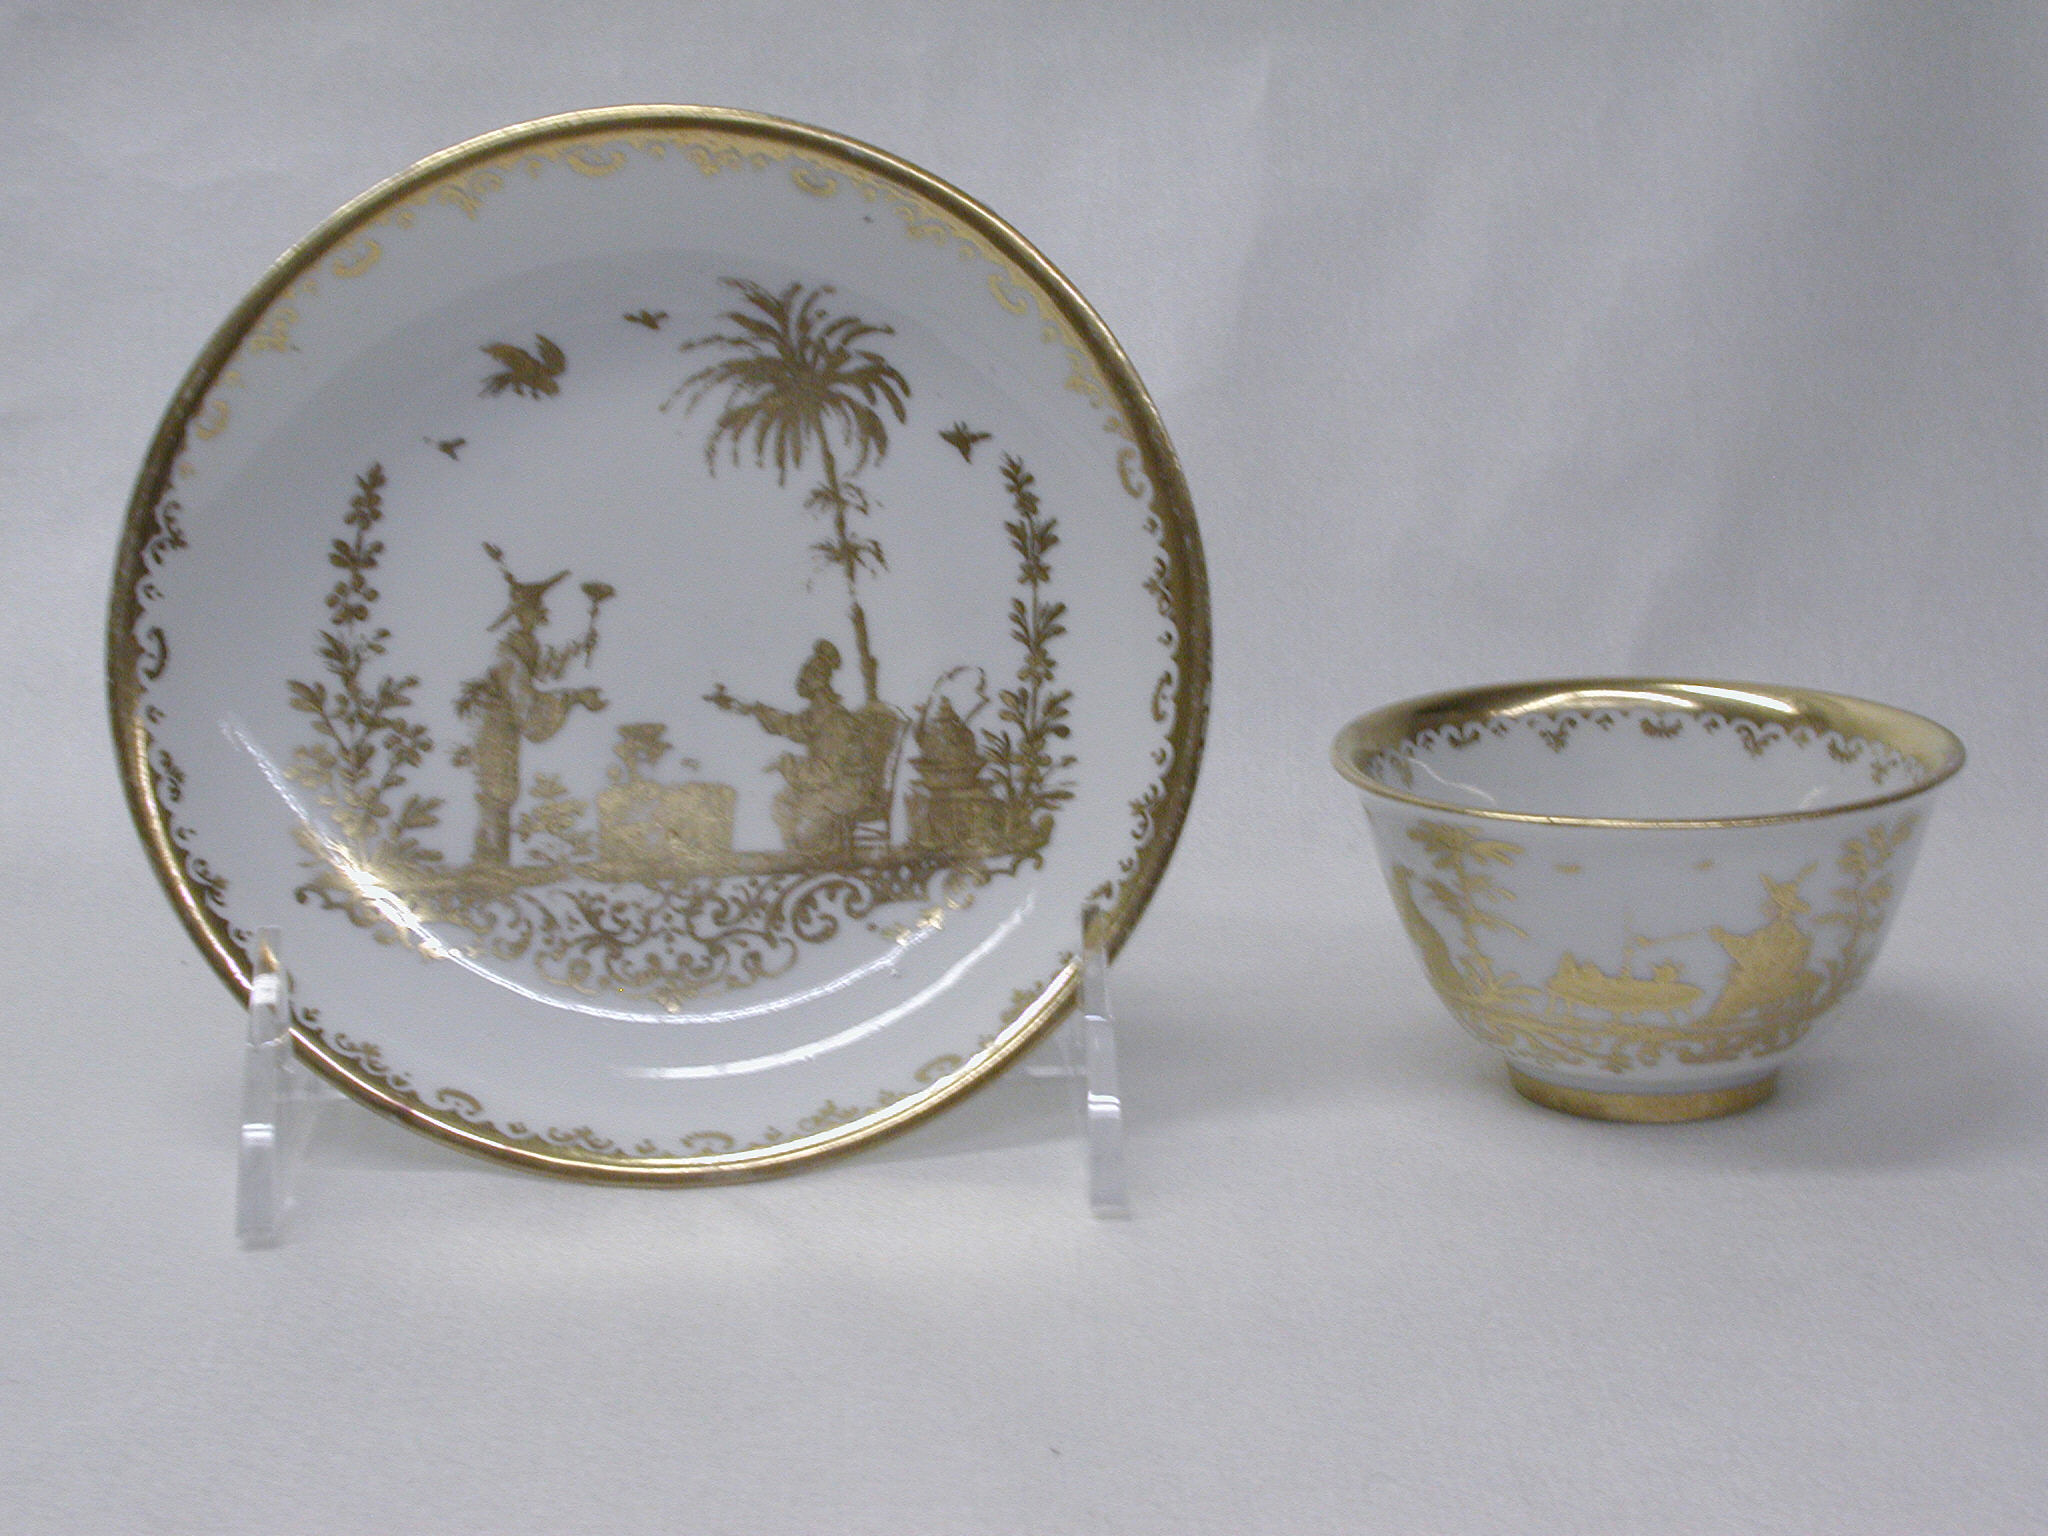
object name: cup and saucer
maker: meissen manufactory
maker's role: manufactory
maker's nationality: german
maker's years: 1710-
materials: hard paste porcelain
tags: human figures,chinoiserie